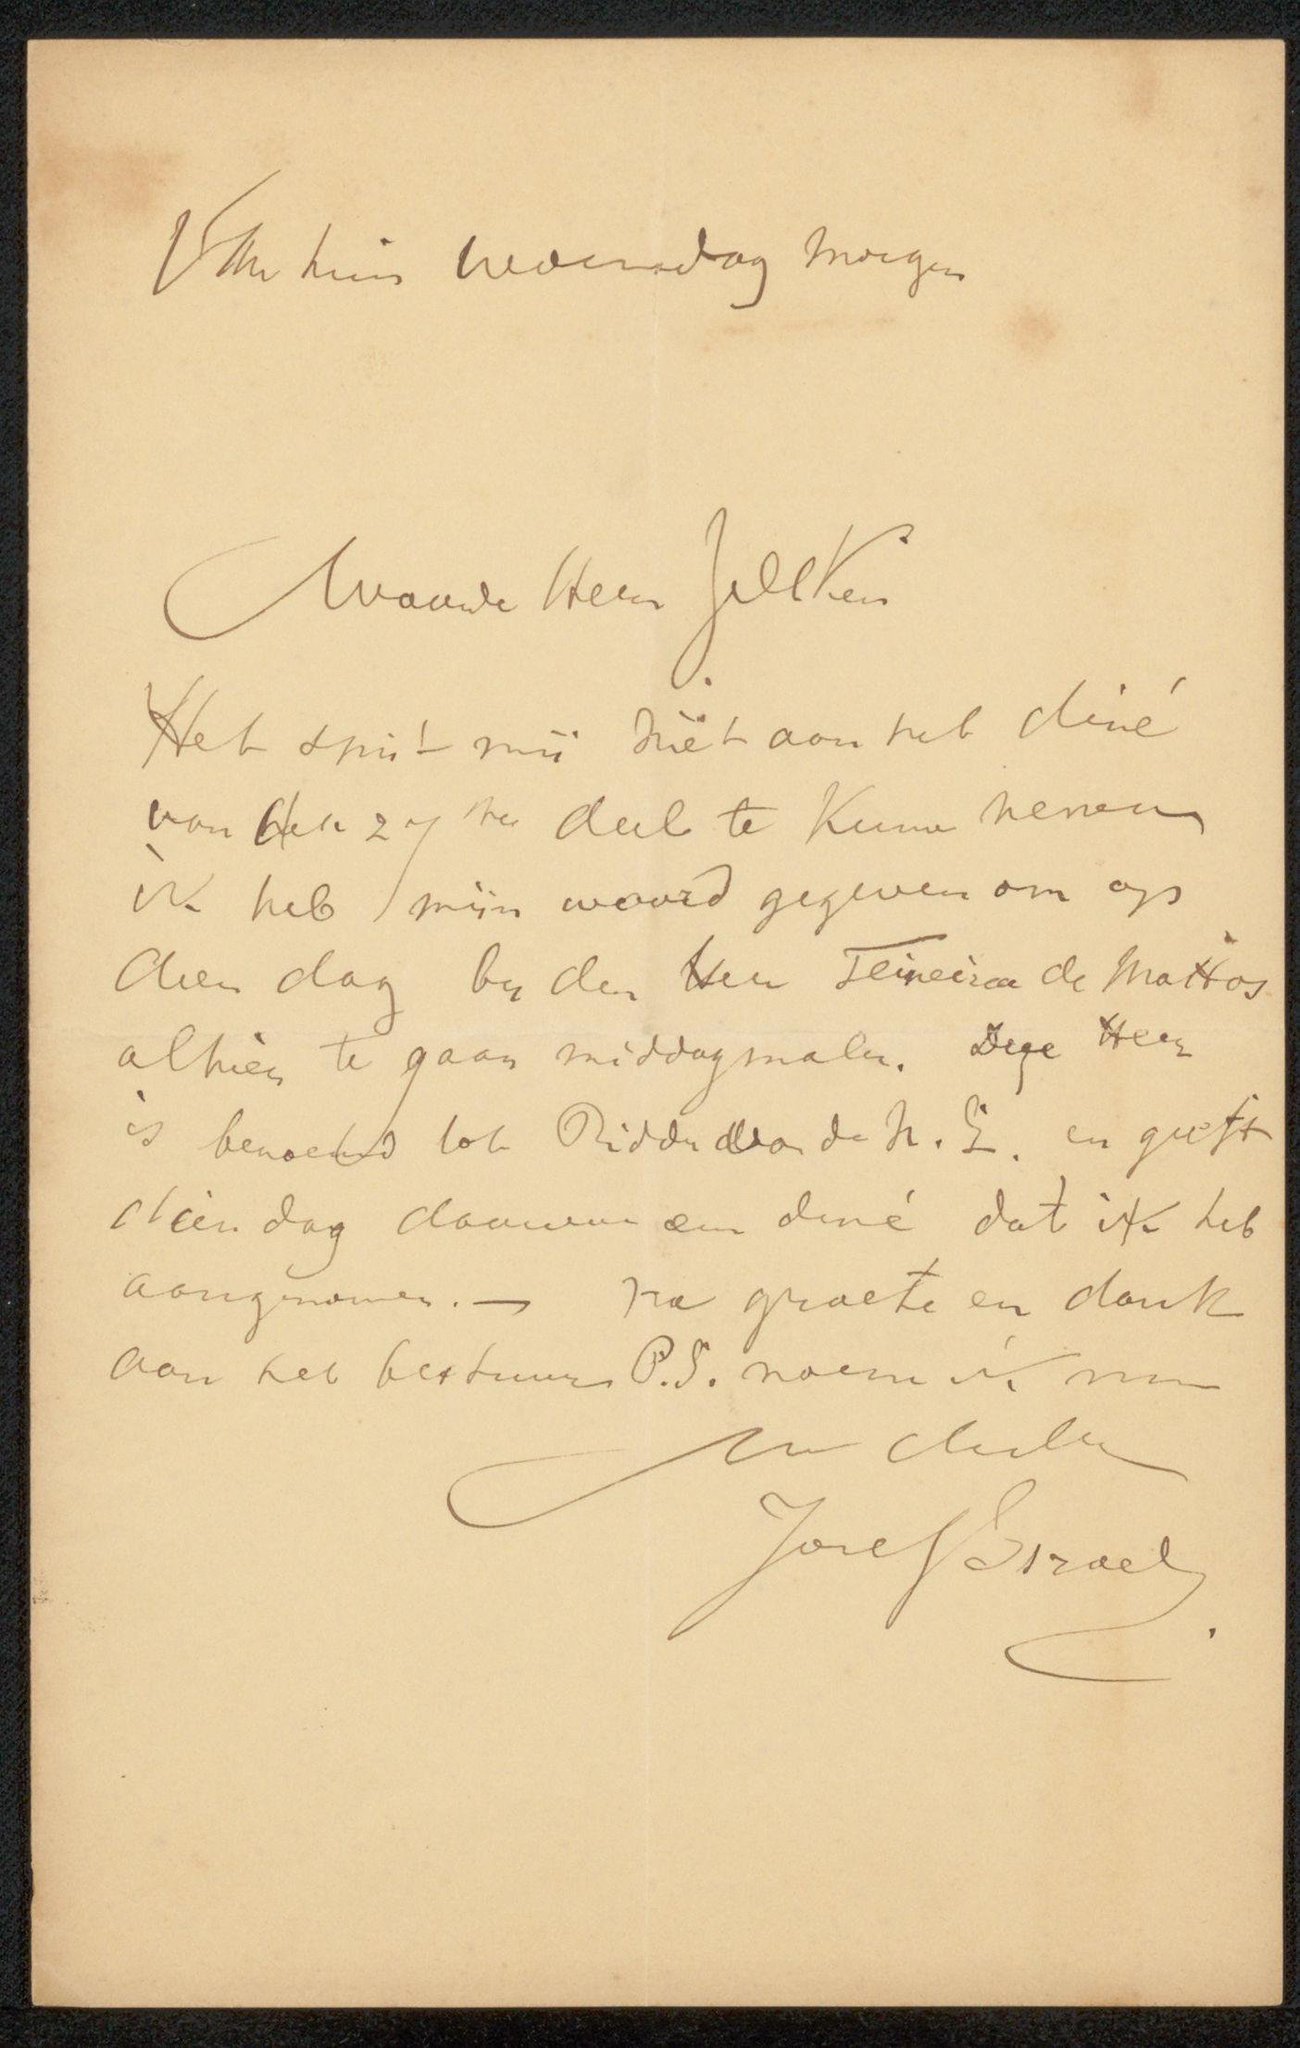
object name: letter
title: Brief aan Philip Zilcken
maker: jozef israëls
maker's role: draughtsman, painter, print maker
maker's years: 1824-1911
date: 1867-1911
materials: ink, paper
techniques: pen, writing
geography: the hague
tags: sculptor, henri teixeira de mattos, philip zilcken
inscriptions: collector's mark: ‘RPK’